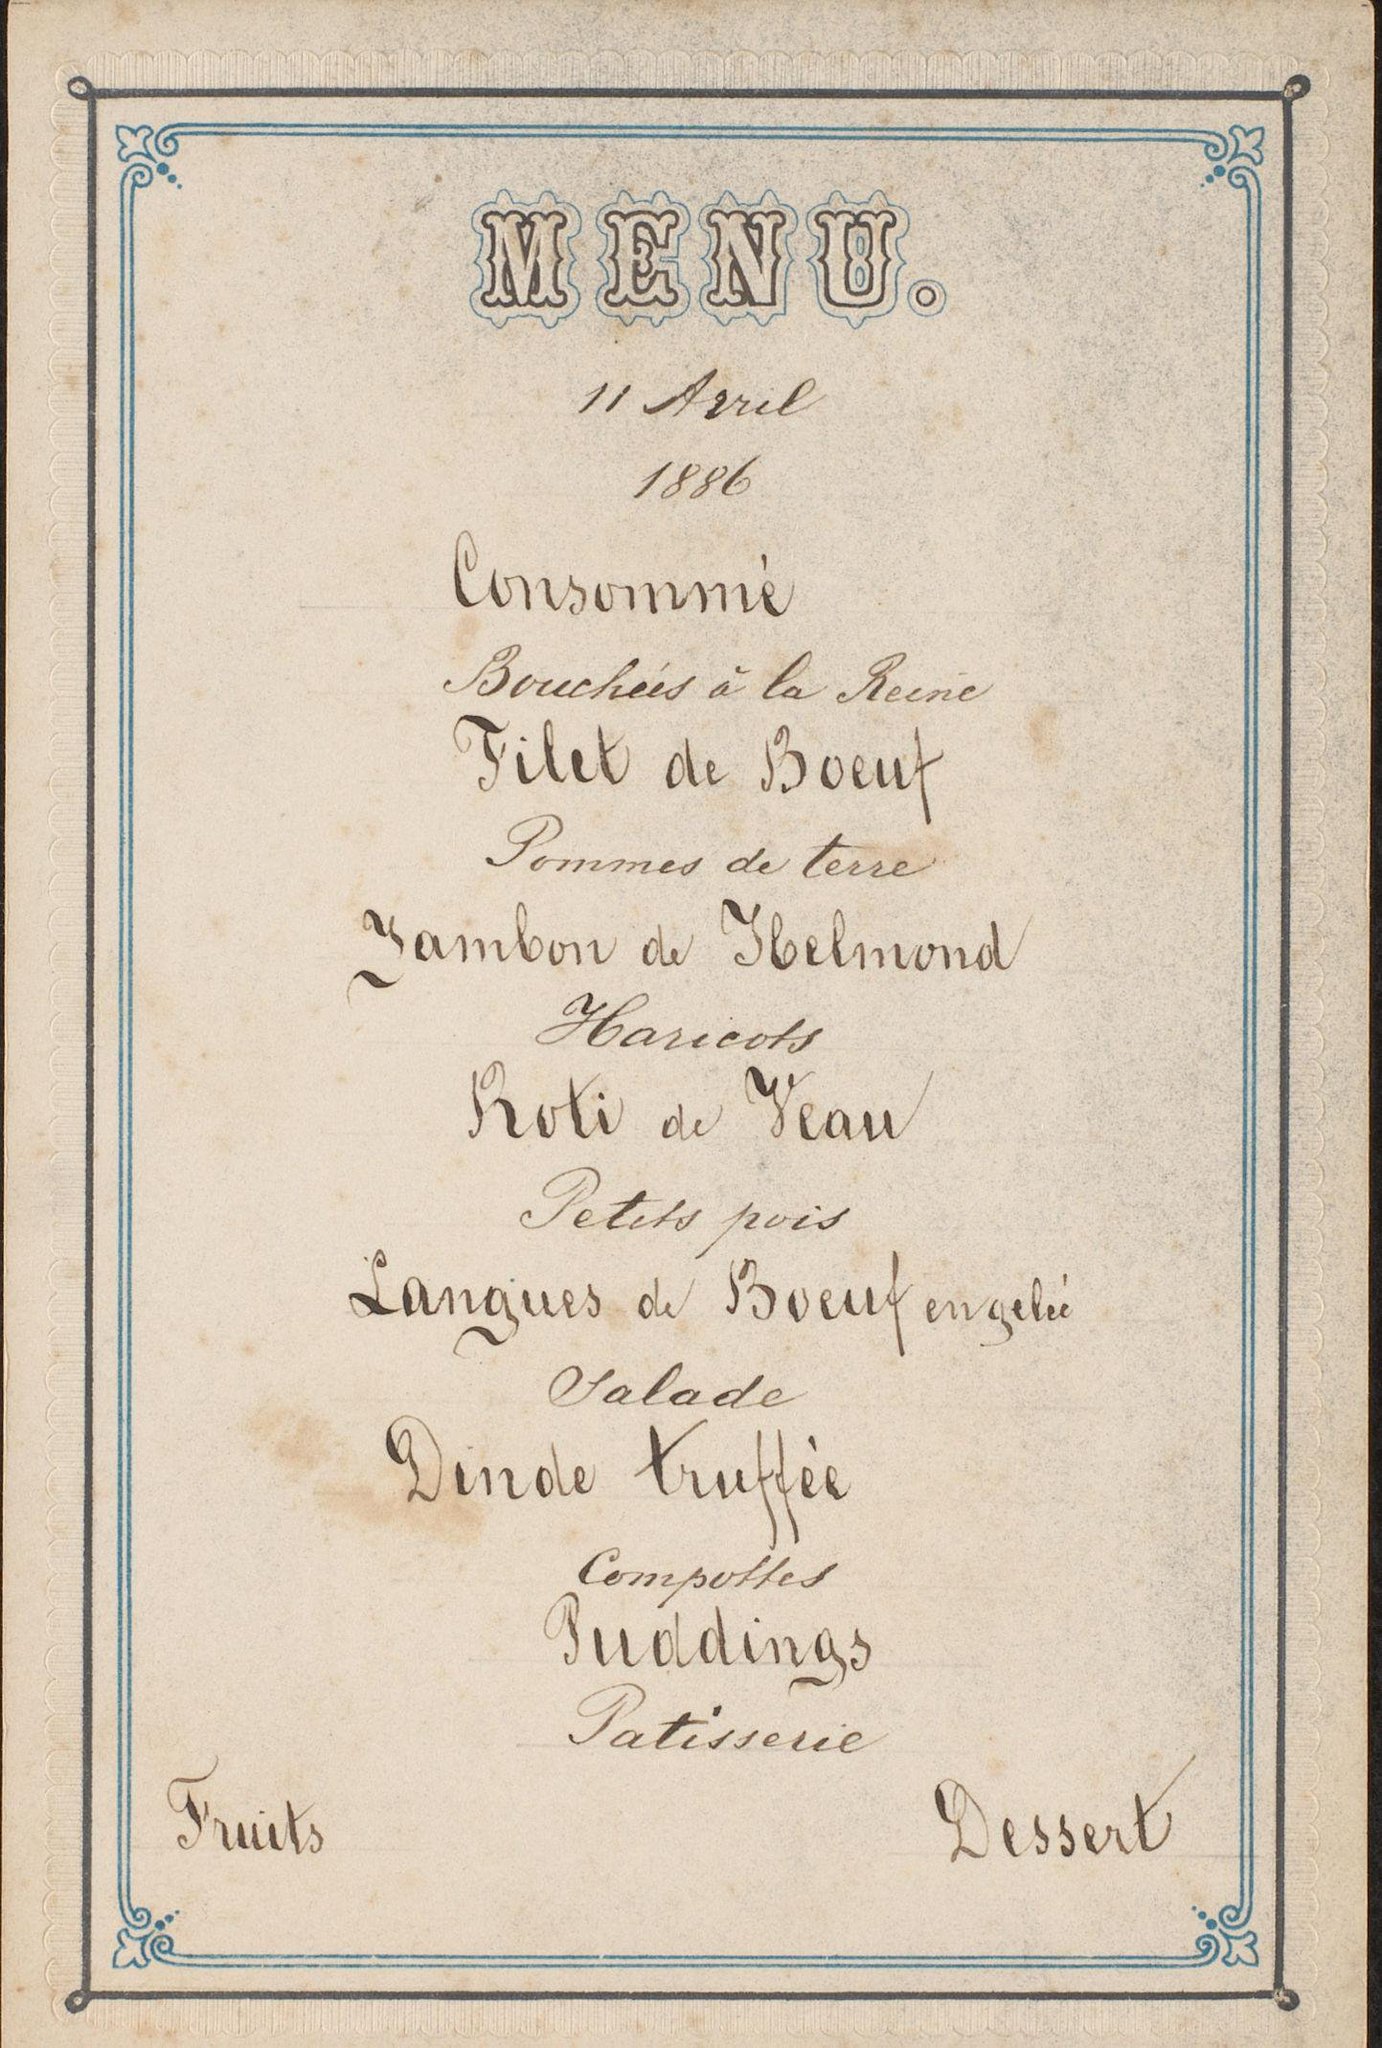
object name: text sheet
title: Menu voor een diner op 11 april 1886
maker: Anonymous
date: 1886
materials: paper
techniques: blind stamped, lithograph, pen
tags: 43b311(+12)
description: Bij gebrek aan gegevens over de vervaardiger is voor de bepaling van de rechten van dit object gebruik gemaakt van de vervaardigingsdatum.